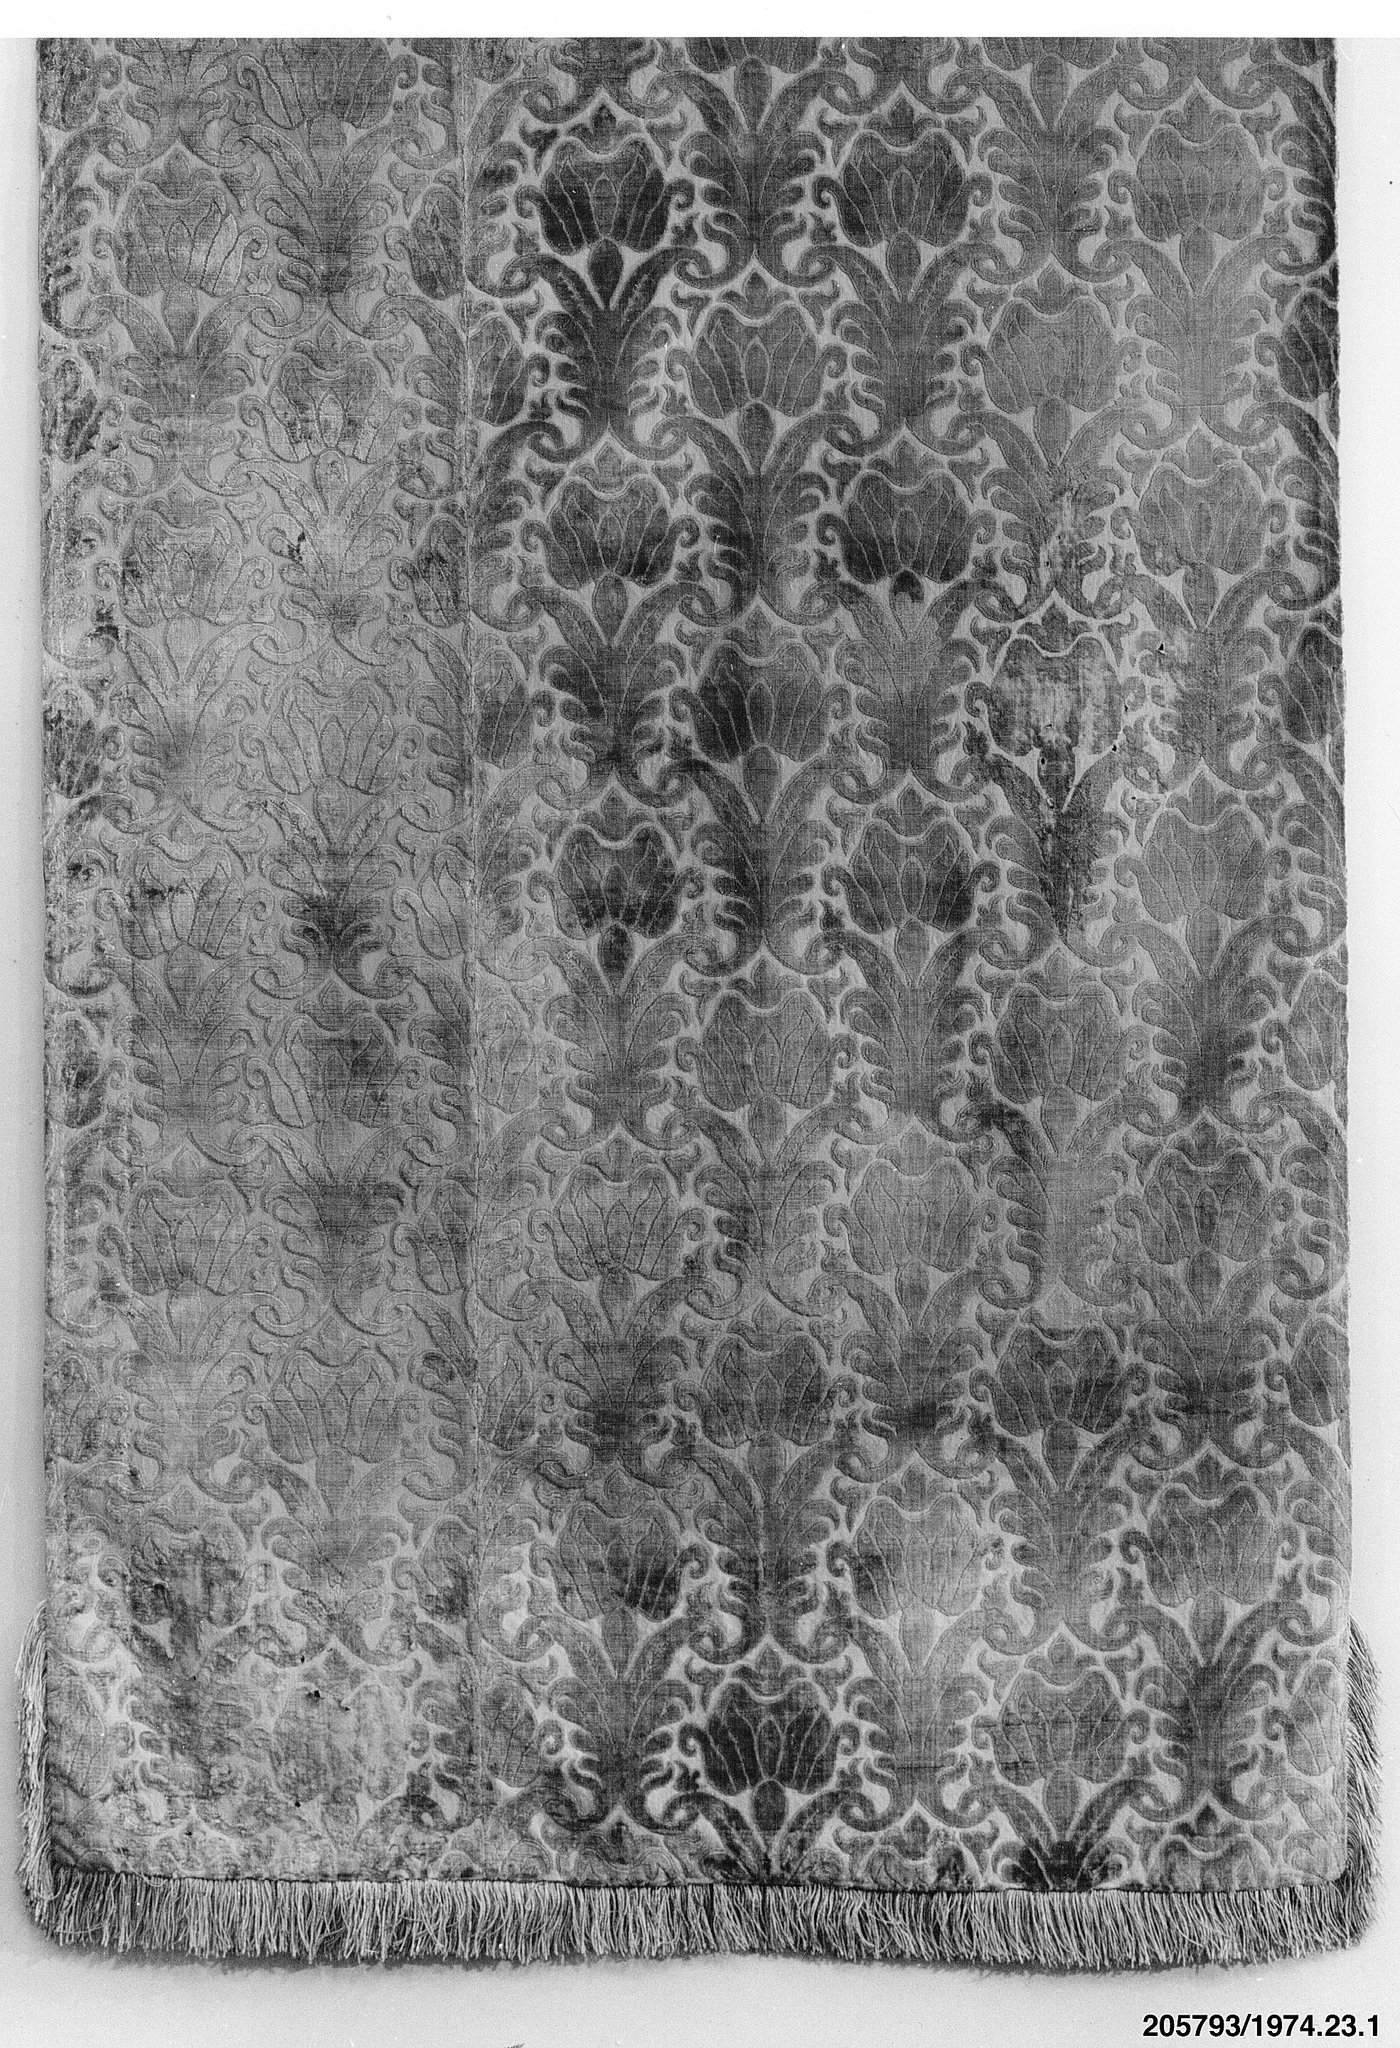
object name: panel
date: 1676-1700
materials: silk